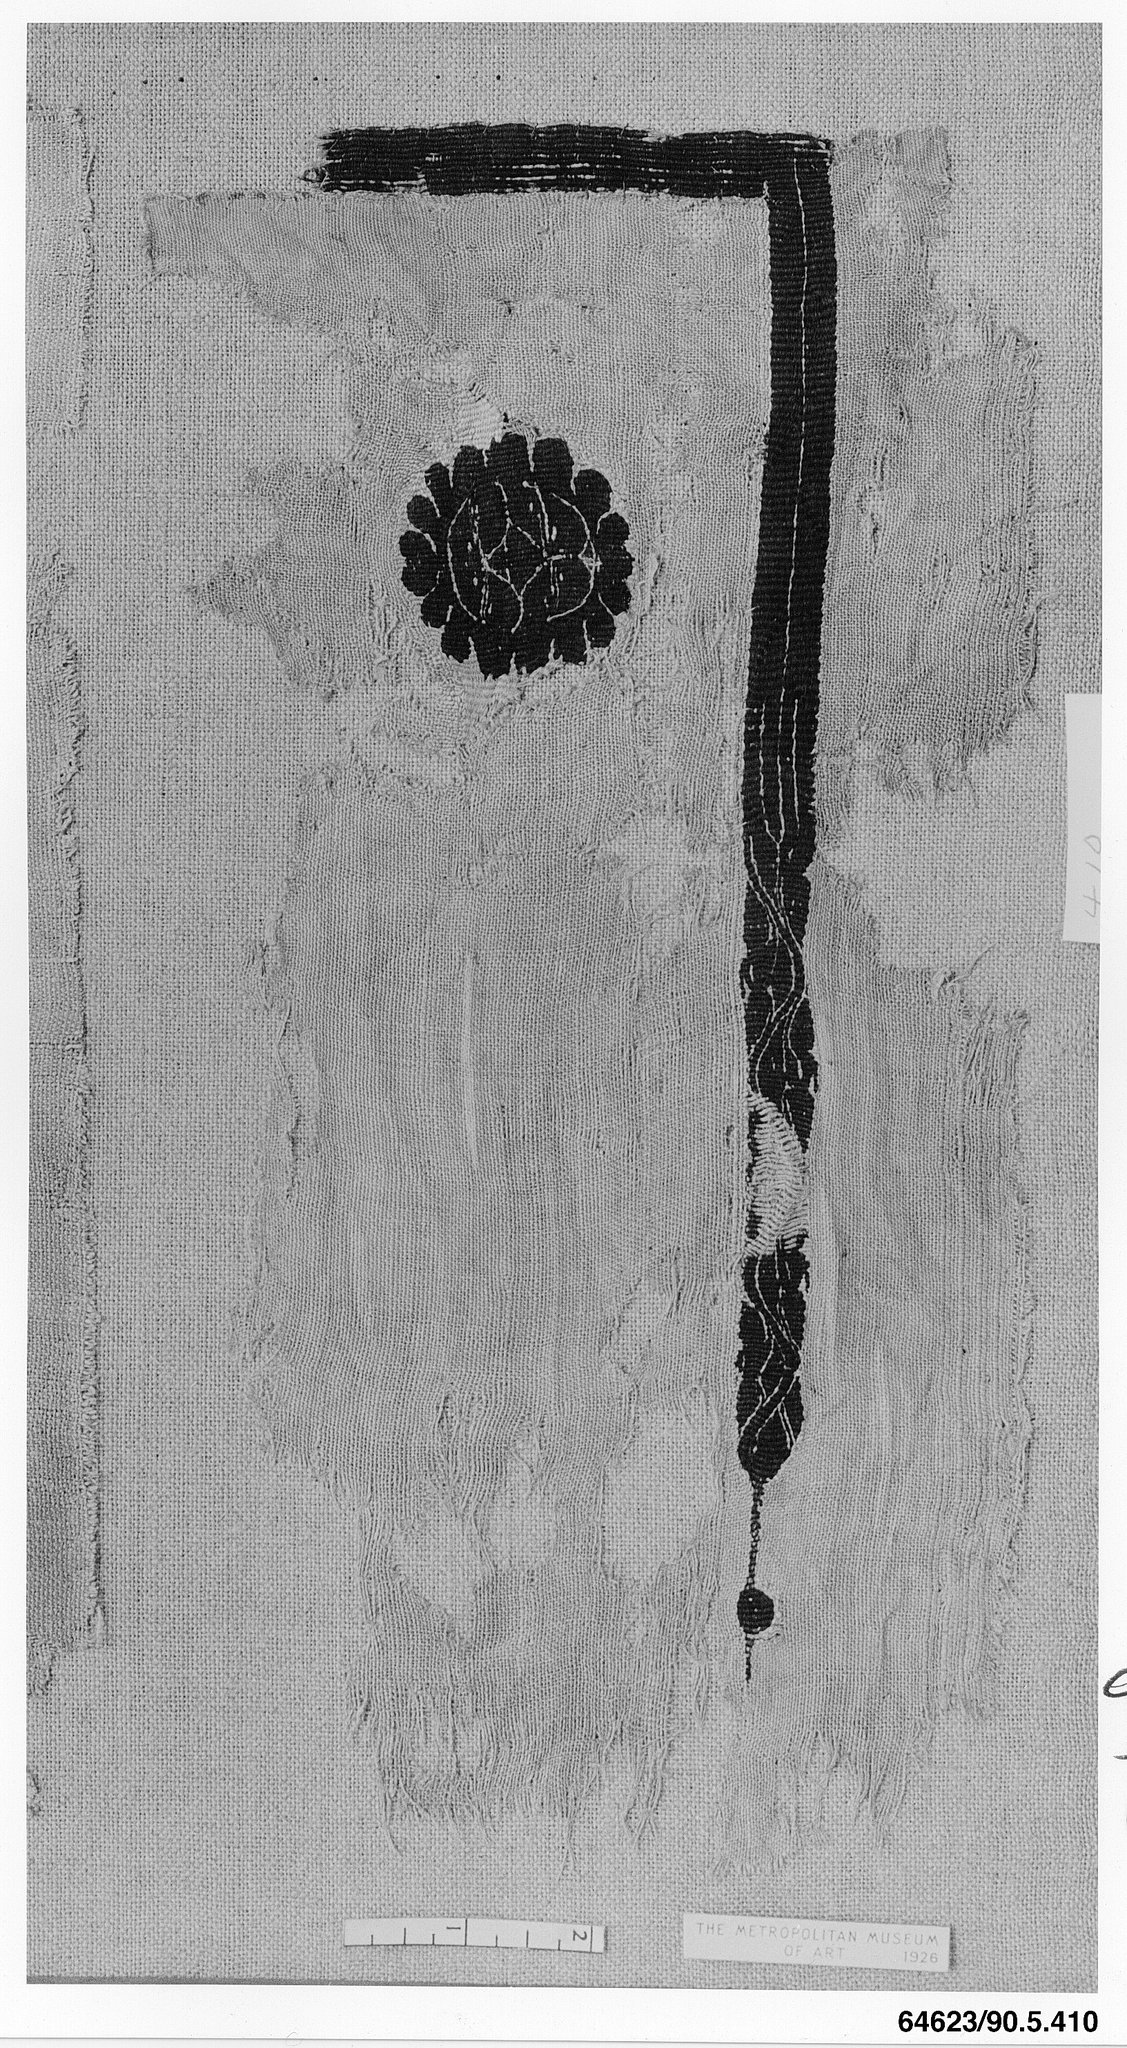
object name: textile fragment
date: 201-400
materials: linen, wool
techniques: weave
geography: egypt